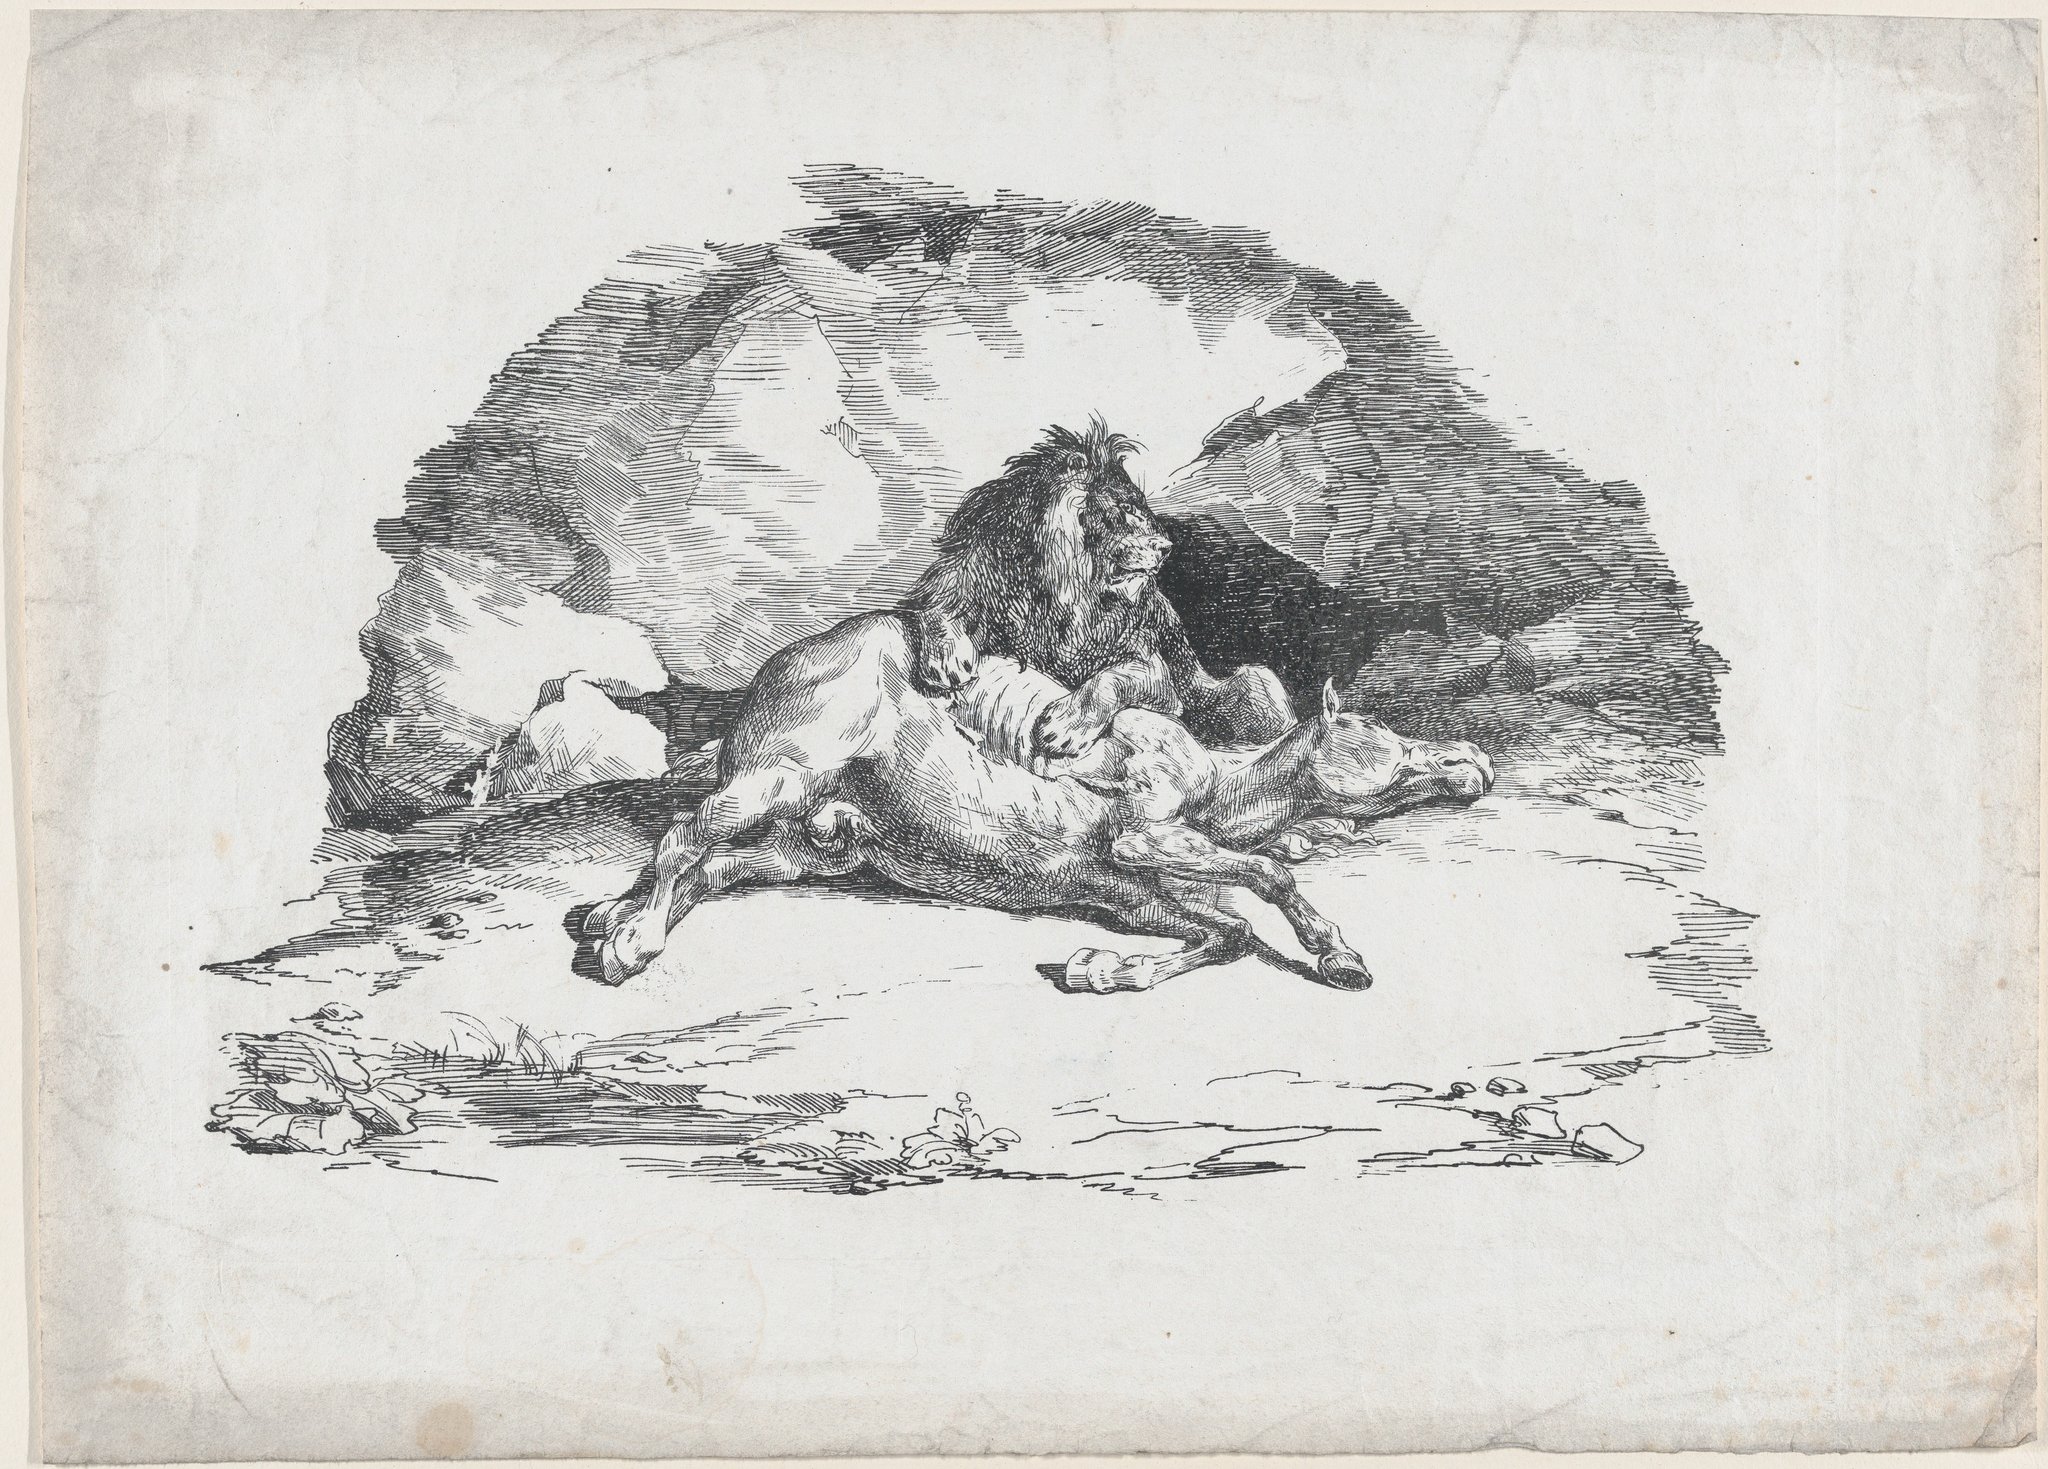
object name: print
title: Lion Devouring a Horse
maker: jean louis andré théodore géricault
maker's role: artist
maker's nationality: french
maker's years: 1791-1824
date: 1818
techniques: lithograph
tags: horses,lions